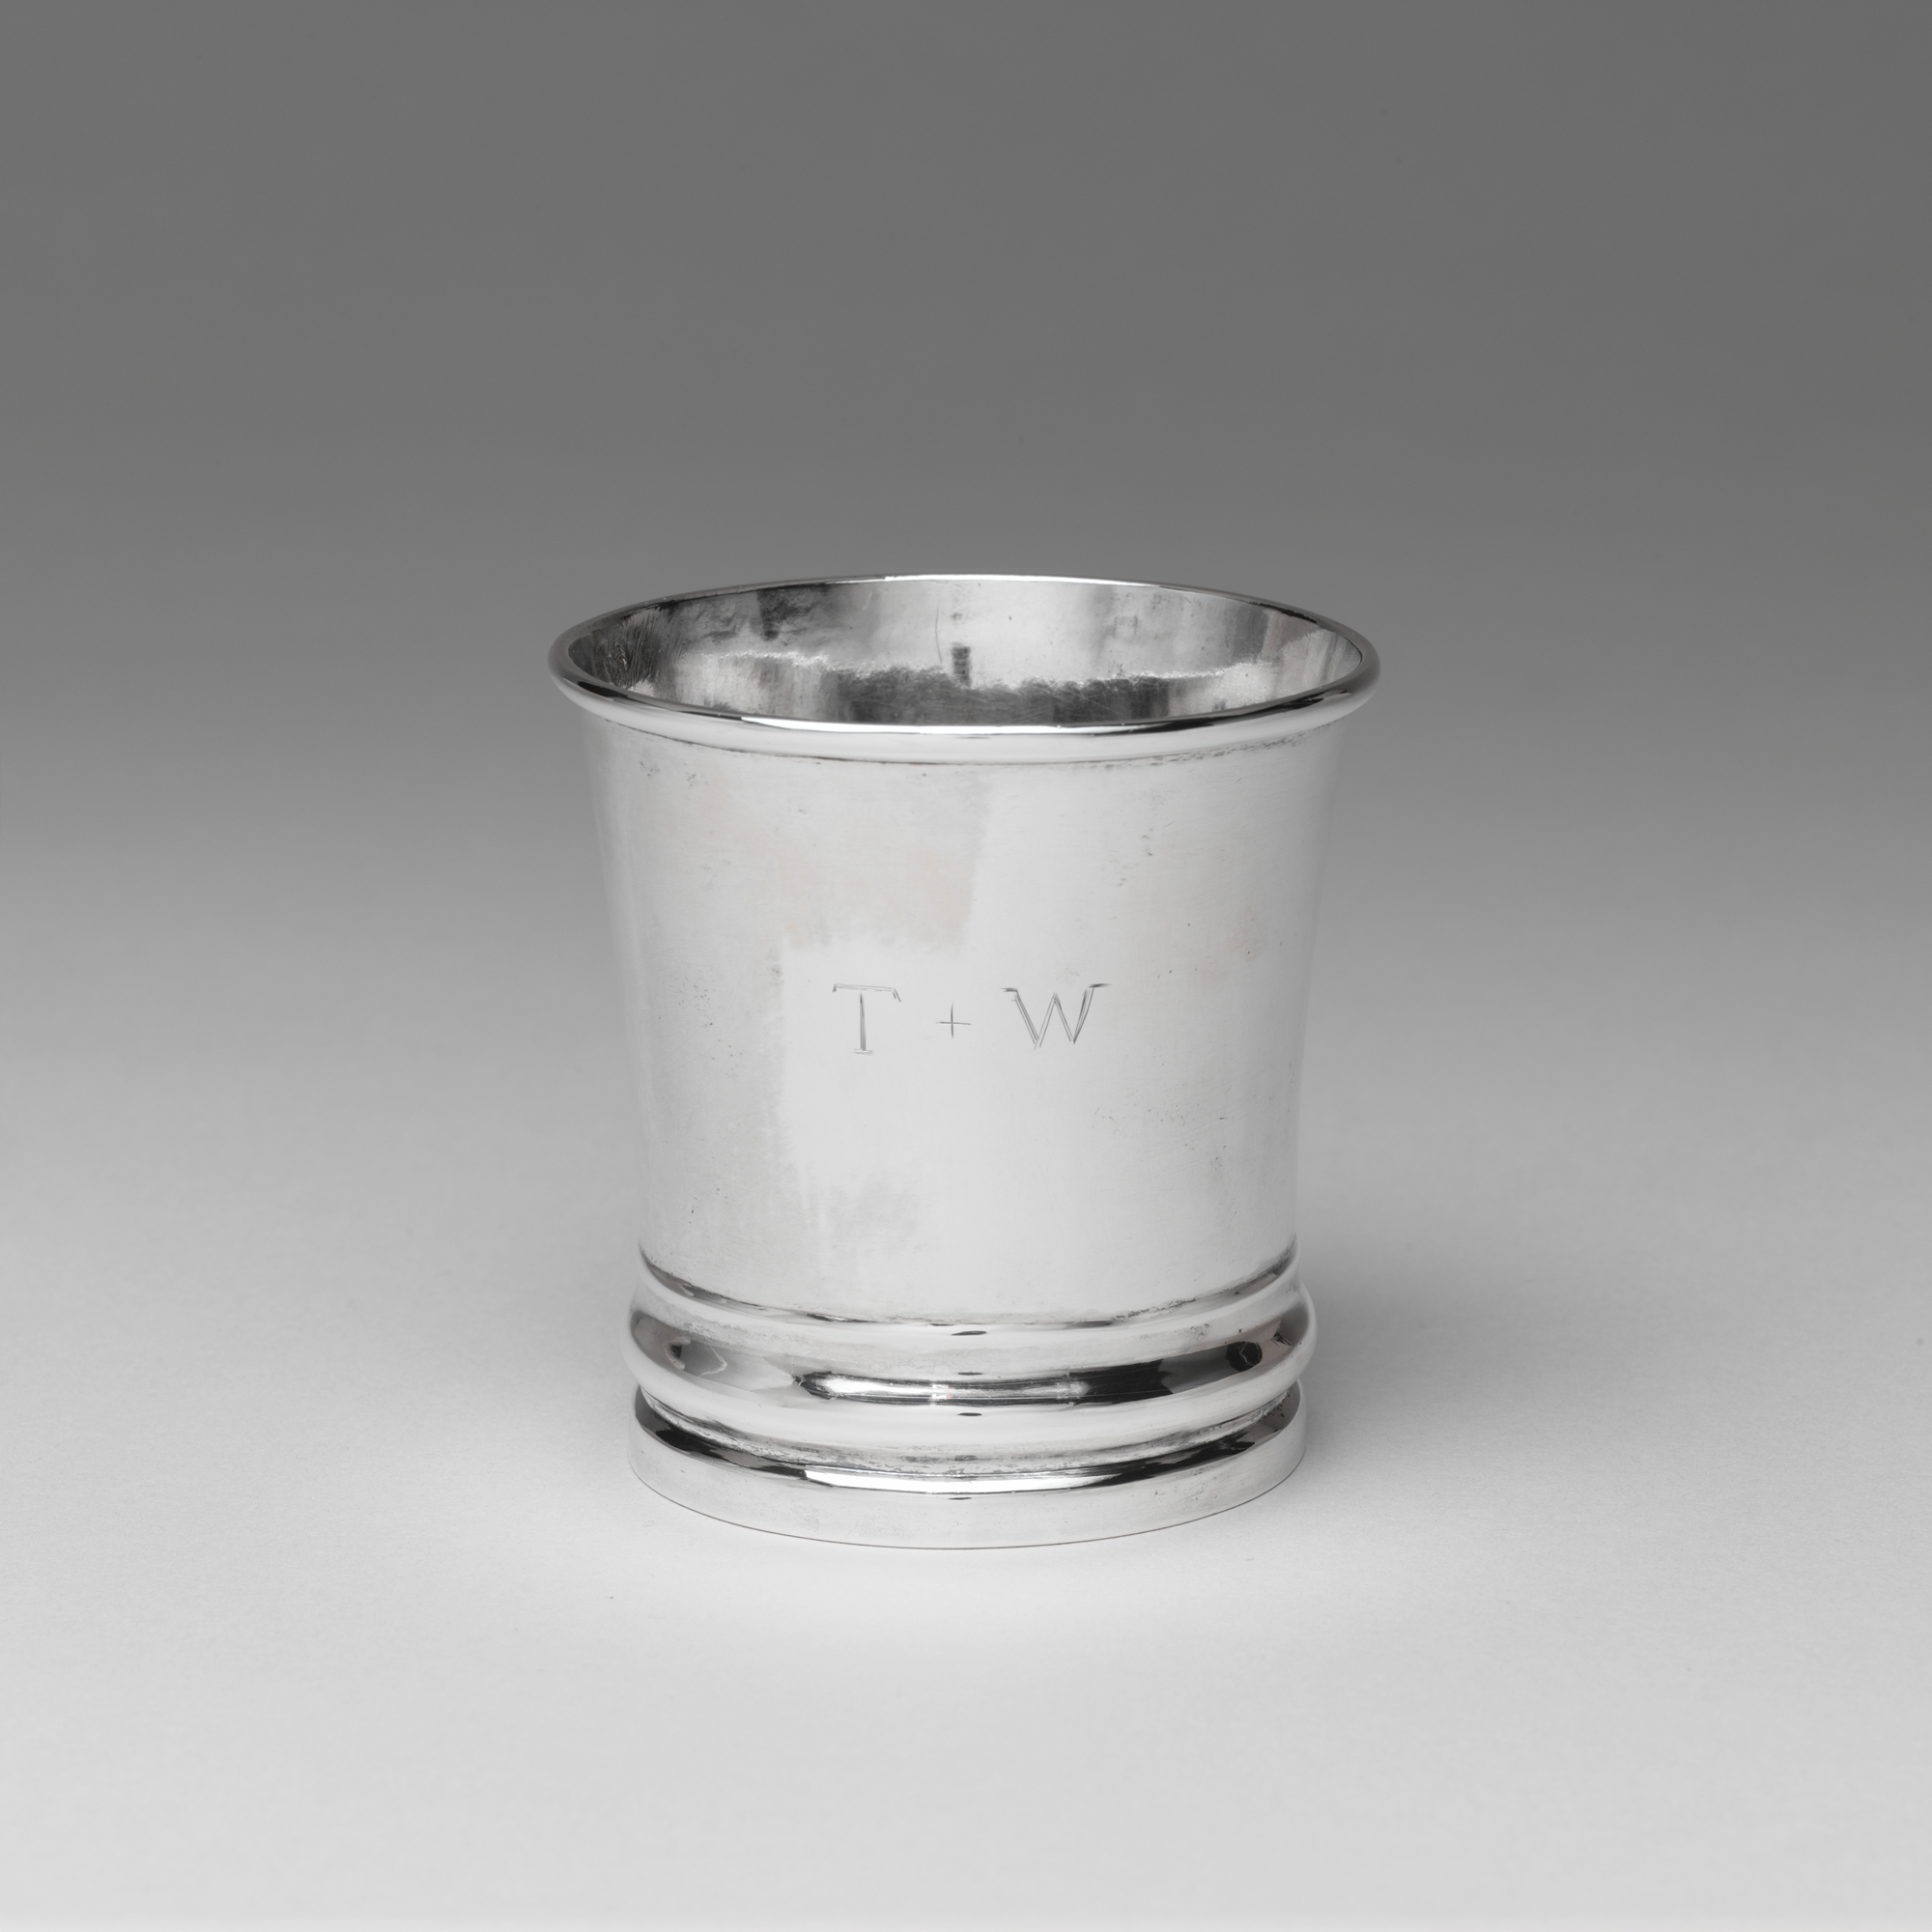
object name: beaker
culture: american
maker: thomas lynde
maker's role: maker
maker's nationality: american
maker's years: 1745-1811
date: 1775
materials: silver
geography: united states